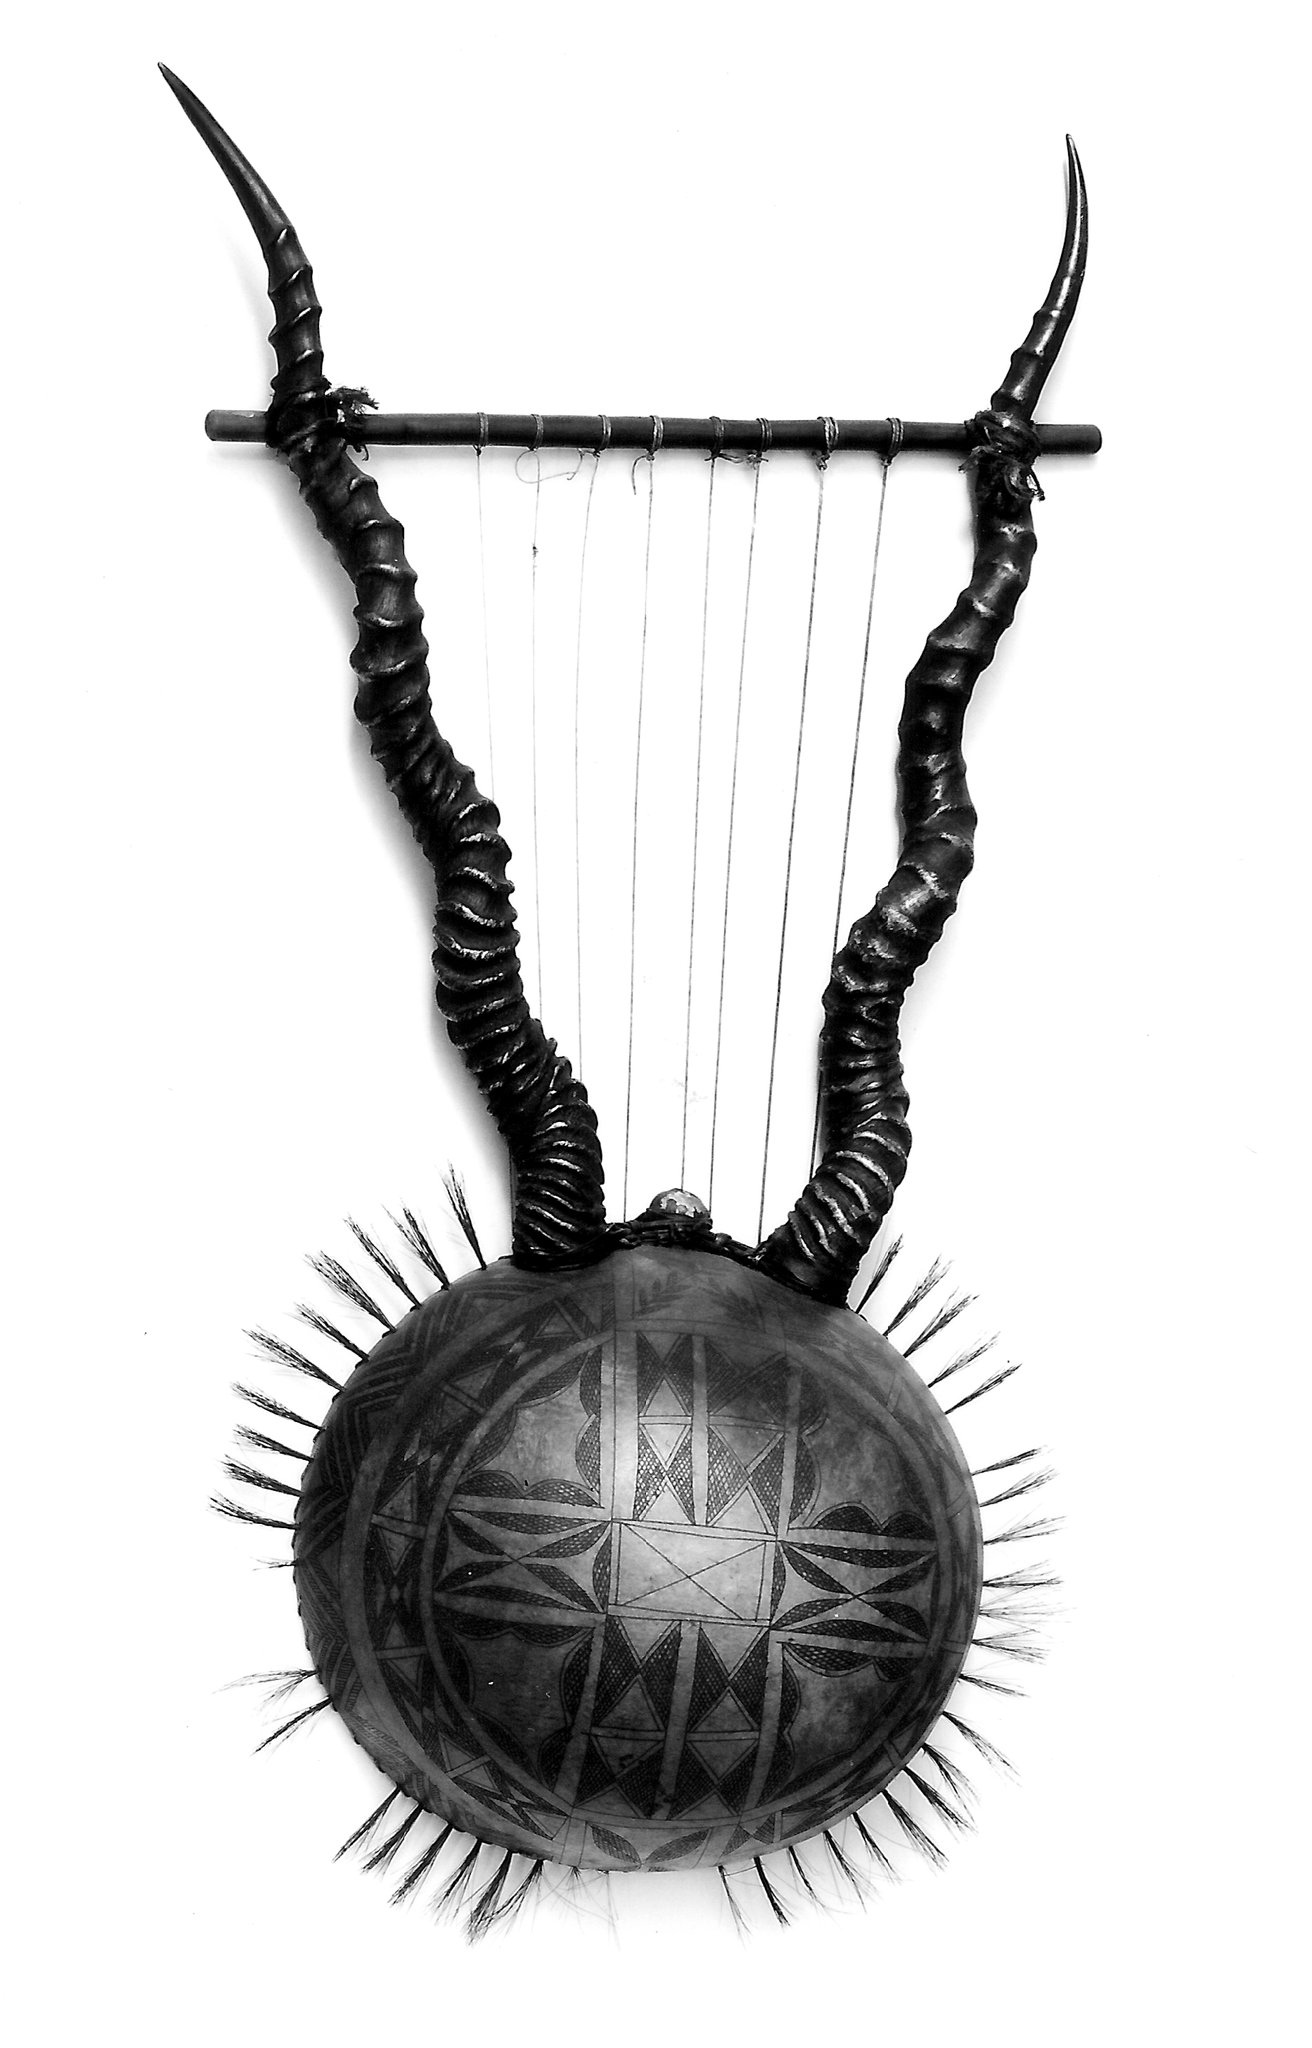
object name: bowl lyre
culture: kenyan or ugandan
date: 1801-1900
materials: horn, skin, wood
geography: uganda